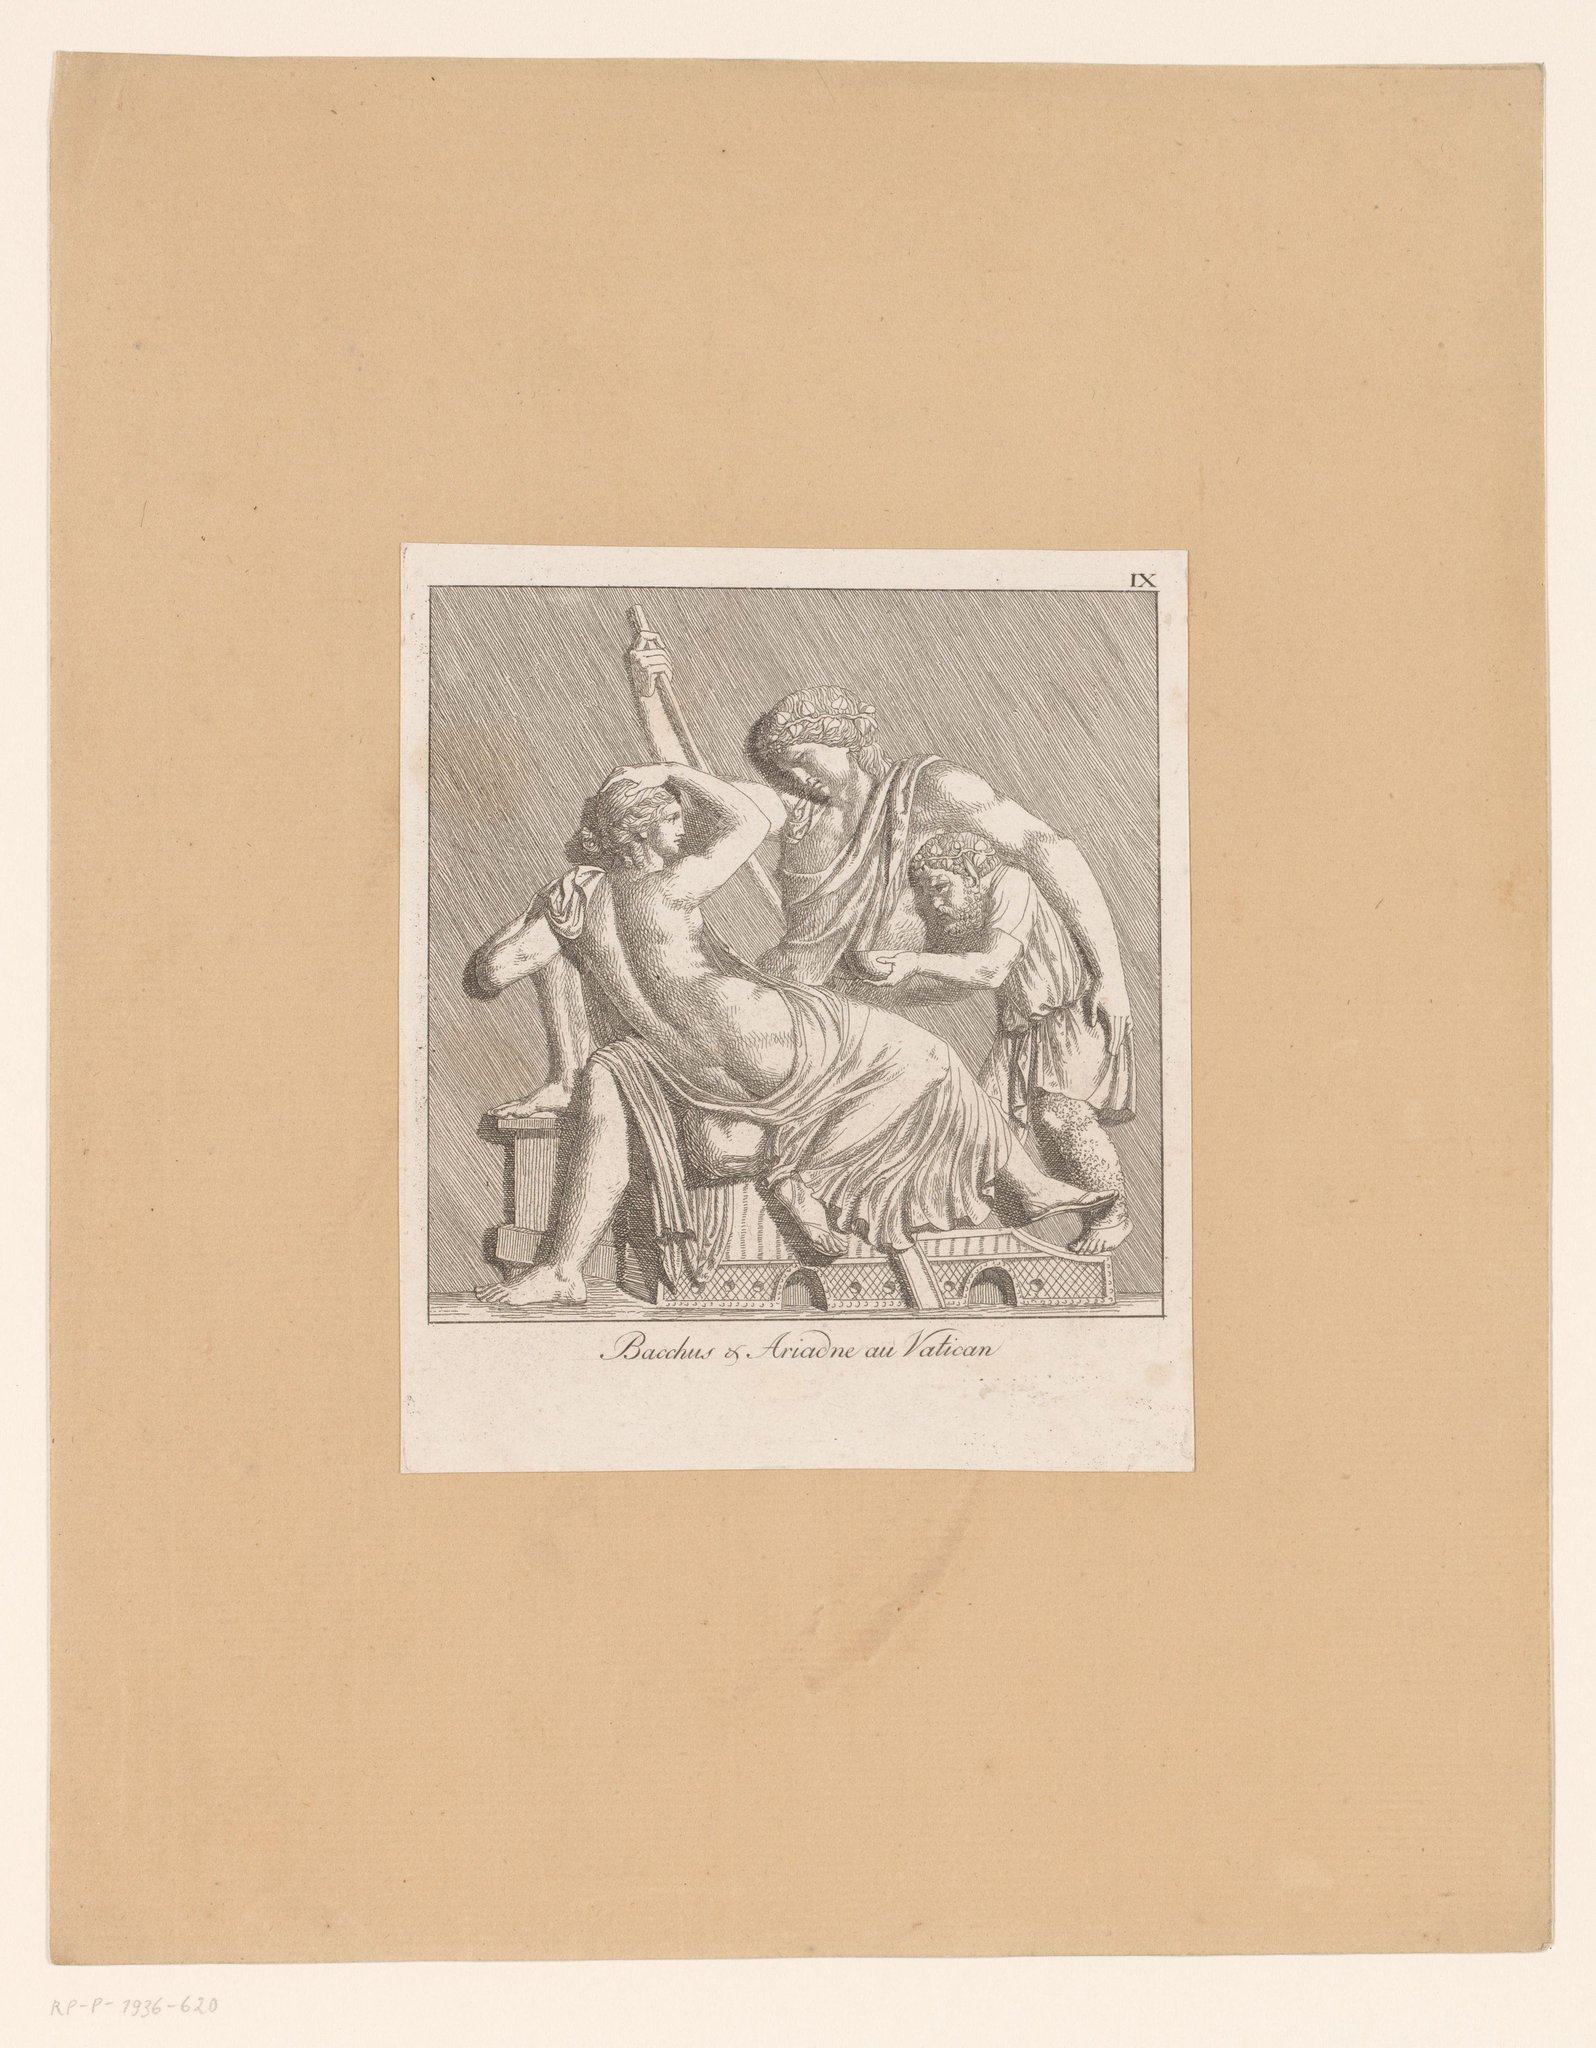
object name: print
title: Bacchus & Ariadne au Vatican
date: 1796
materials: paper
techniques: etching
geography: france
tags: (story of) ariadne and bacchus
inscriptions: collector's mark: Lugt 2228